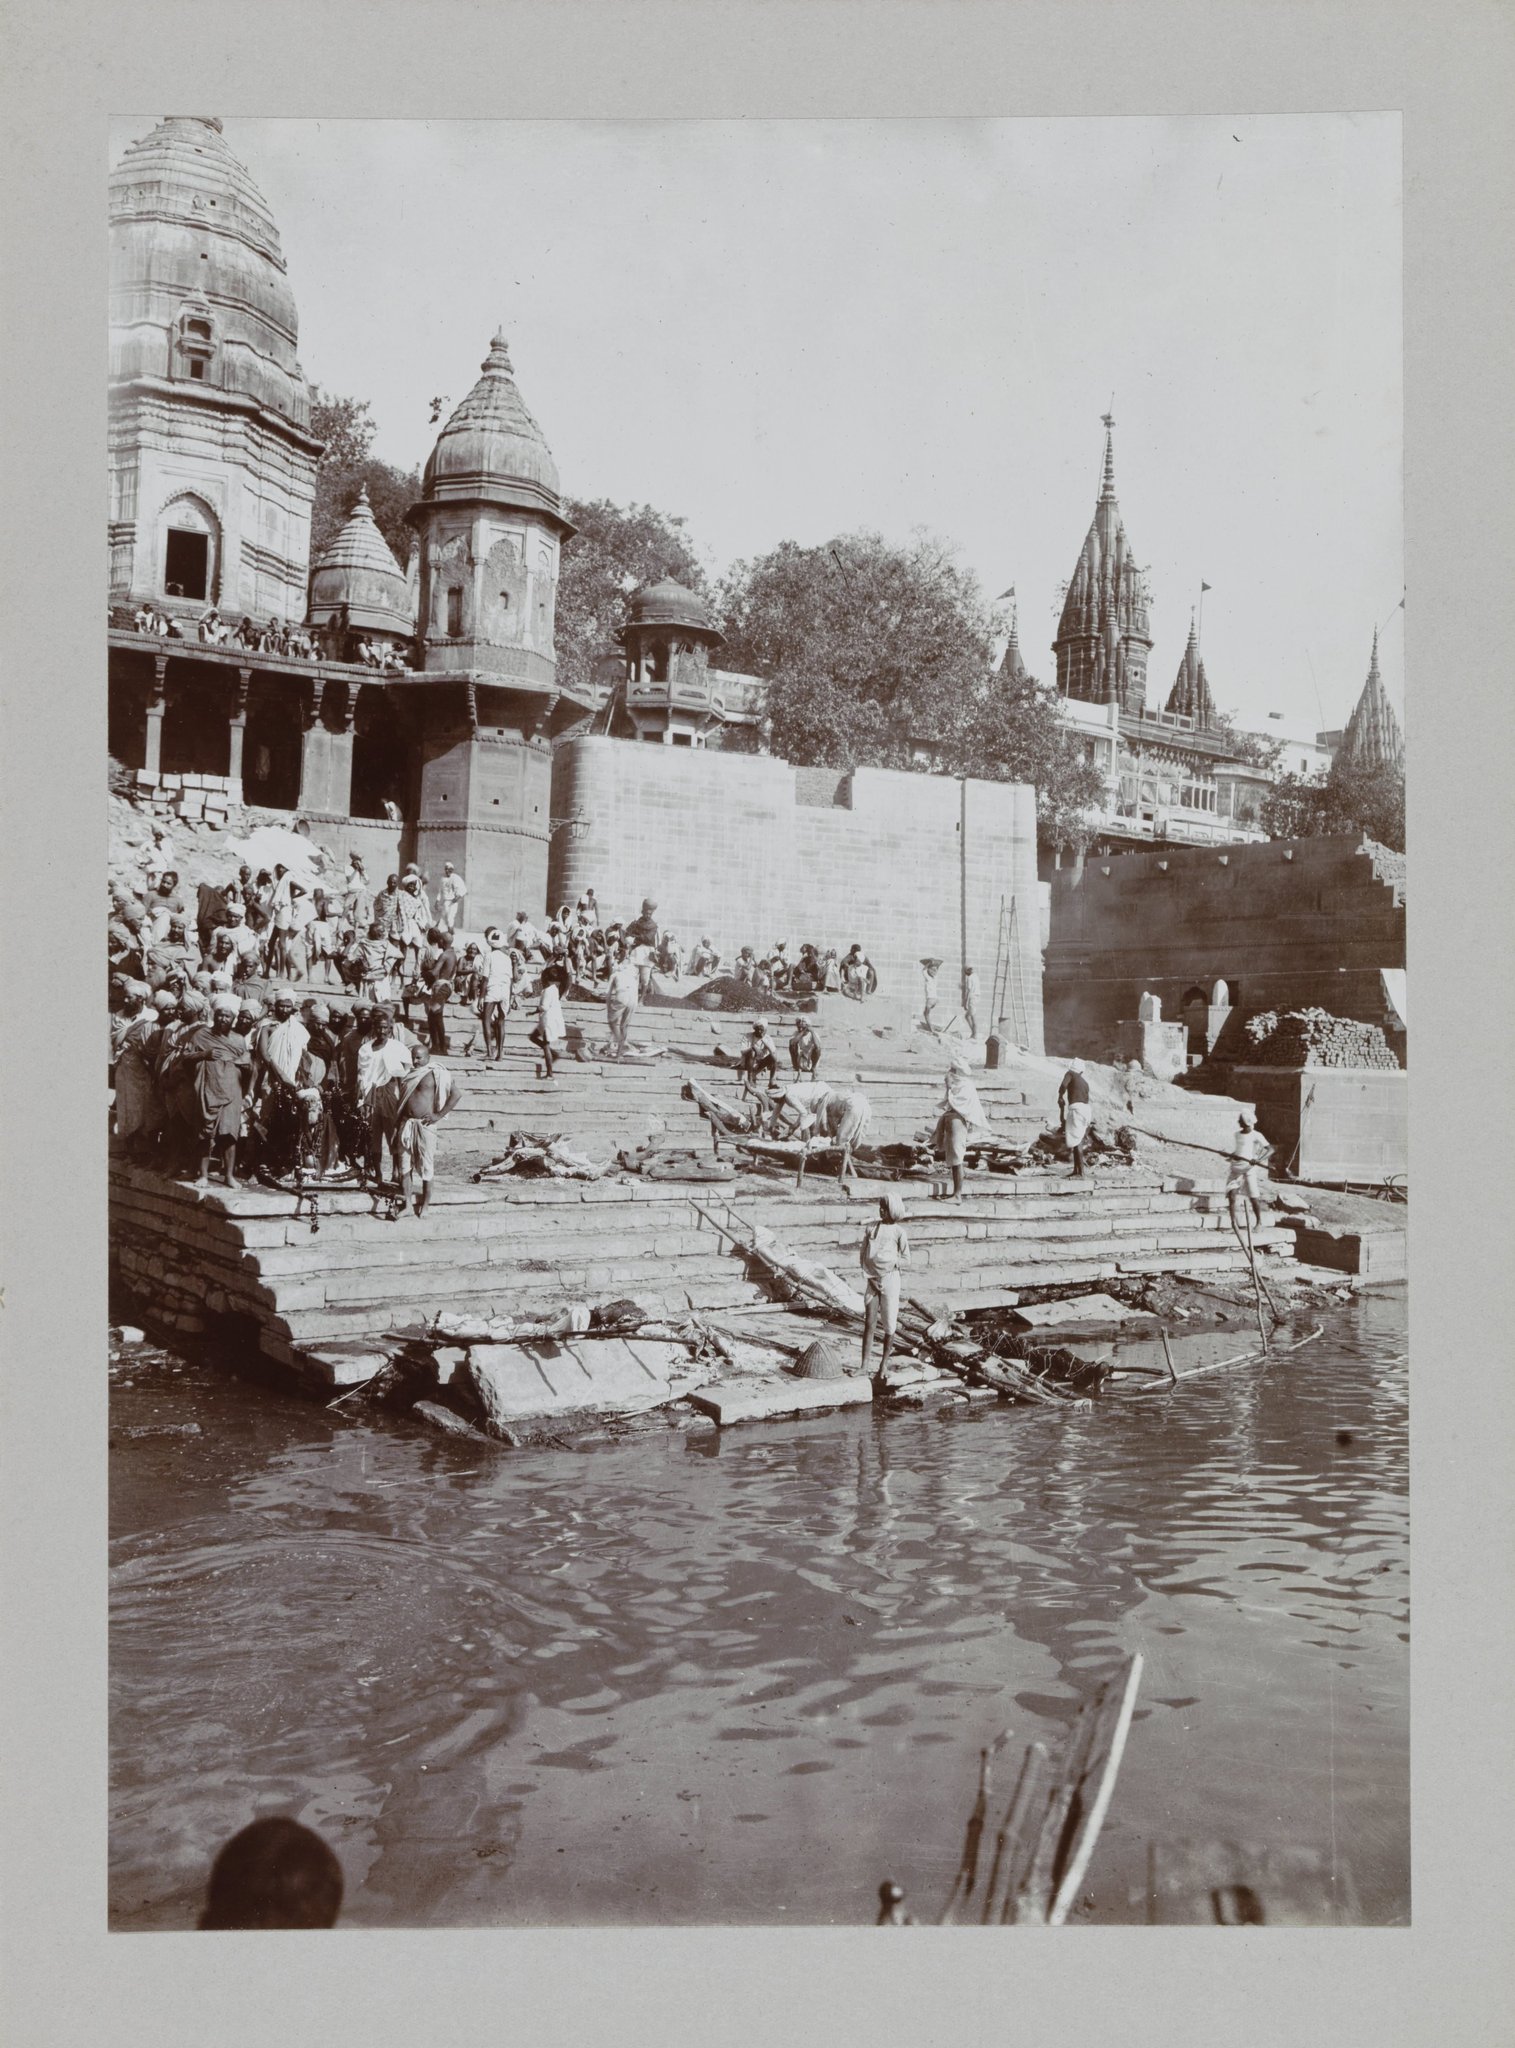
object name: photograph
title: Ghat in Varanasi, Uttar Pradesh, India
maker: Anonymous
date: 1895-1915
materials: cardboard, paper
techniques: gelatin silver print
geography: varanasi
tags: ghats van varanasi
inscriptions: annotation: ‘7. Benares (Ghat, alwaar de dooden verbrand worden.)’